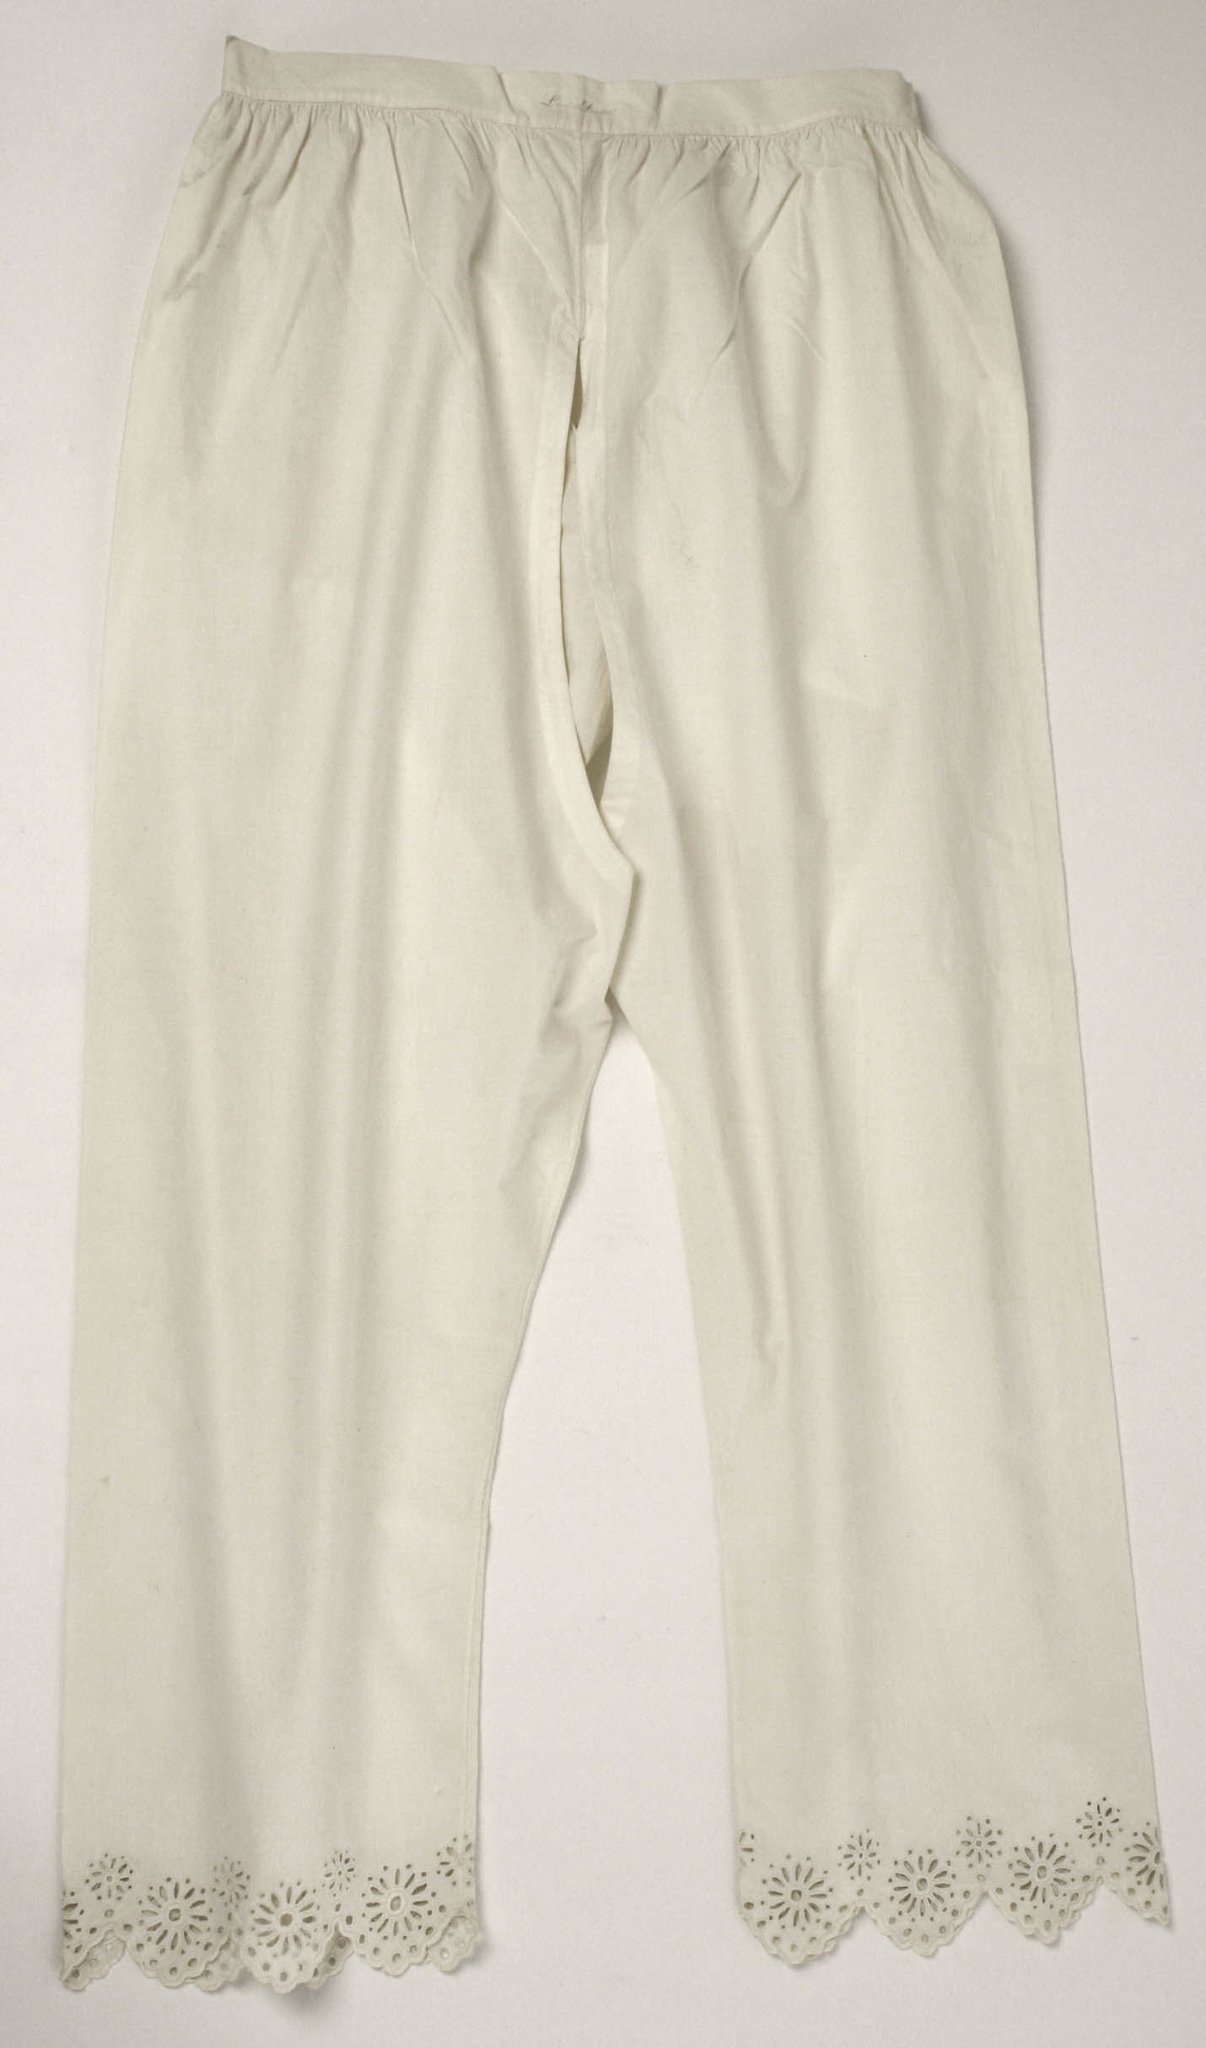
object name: pantalets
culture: american or european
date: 1802-1820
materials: cotton